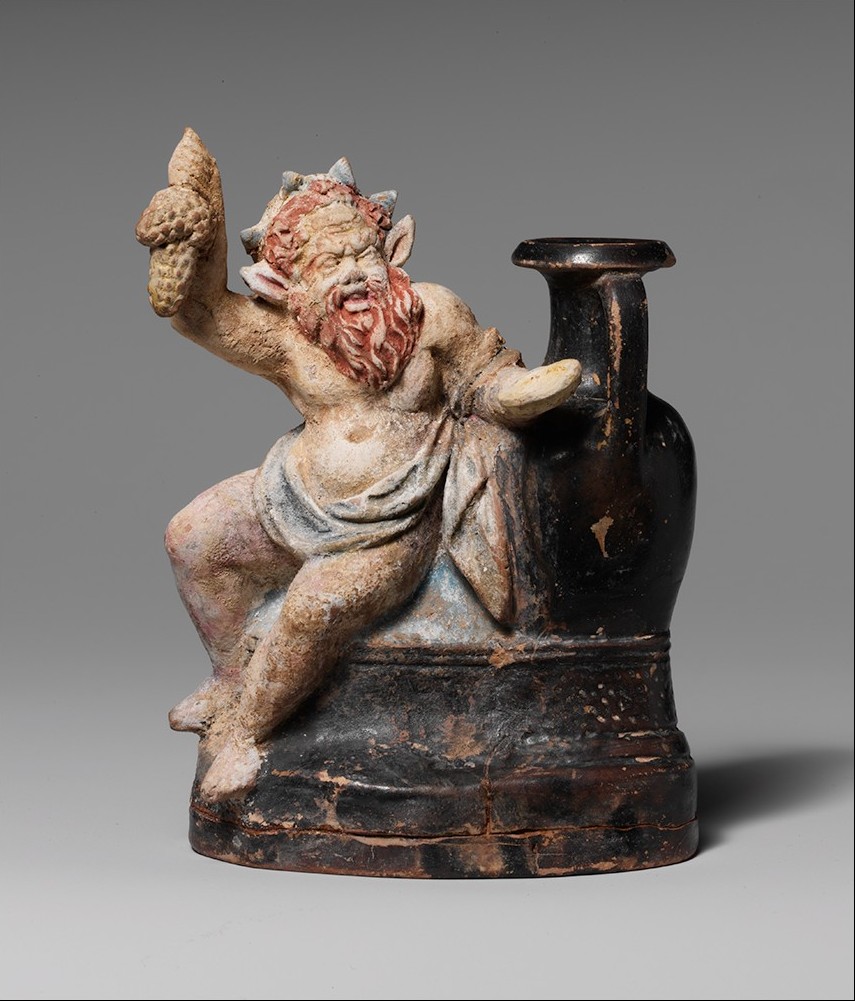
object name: vase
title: Terracotta vase in the form of a seated silen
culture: greek, attic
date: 400-301 BCE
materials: terracotta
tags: grapes,silenus